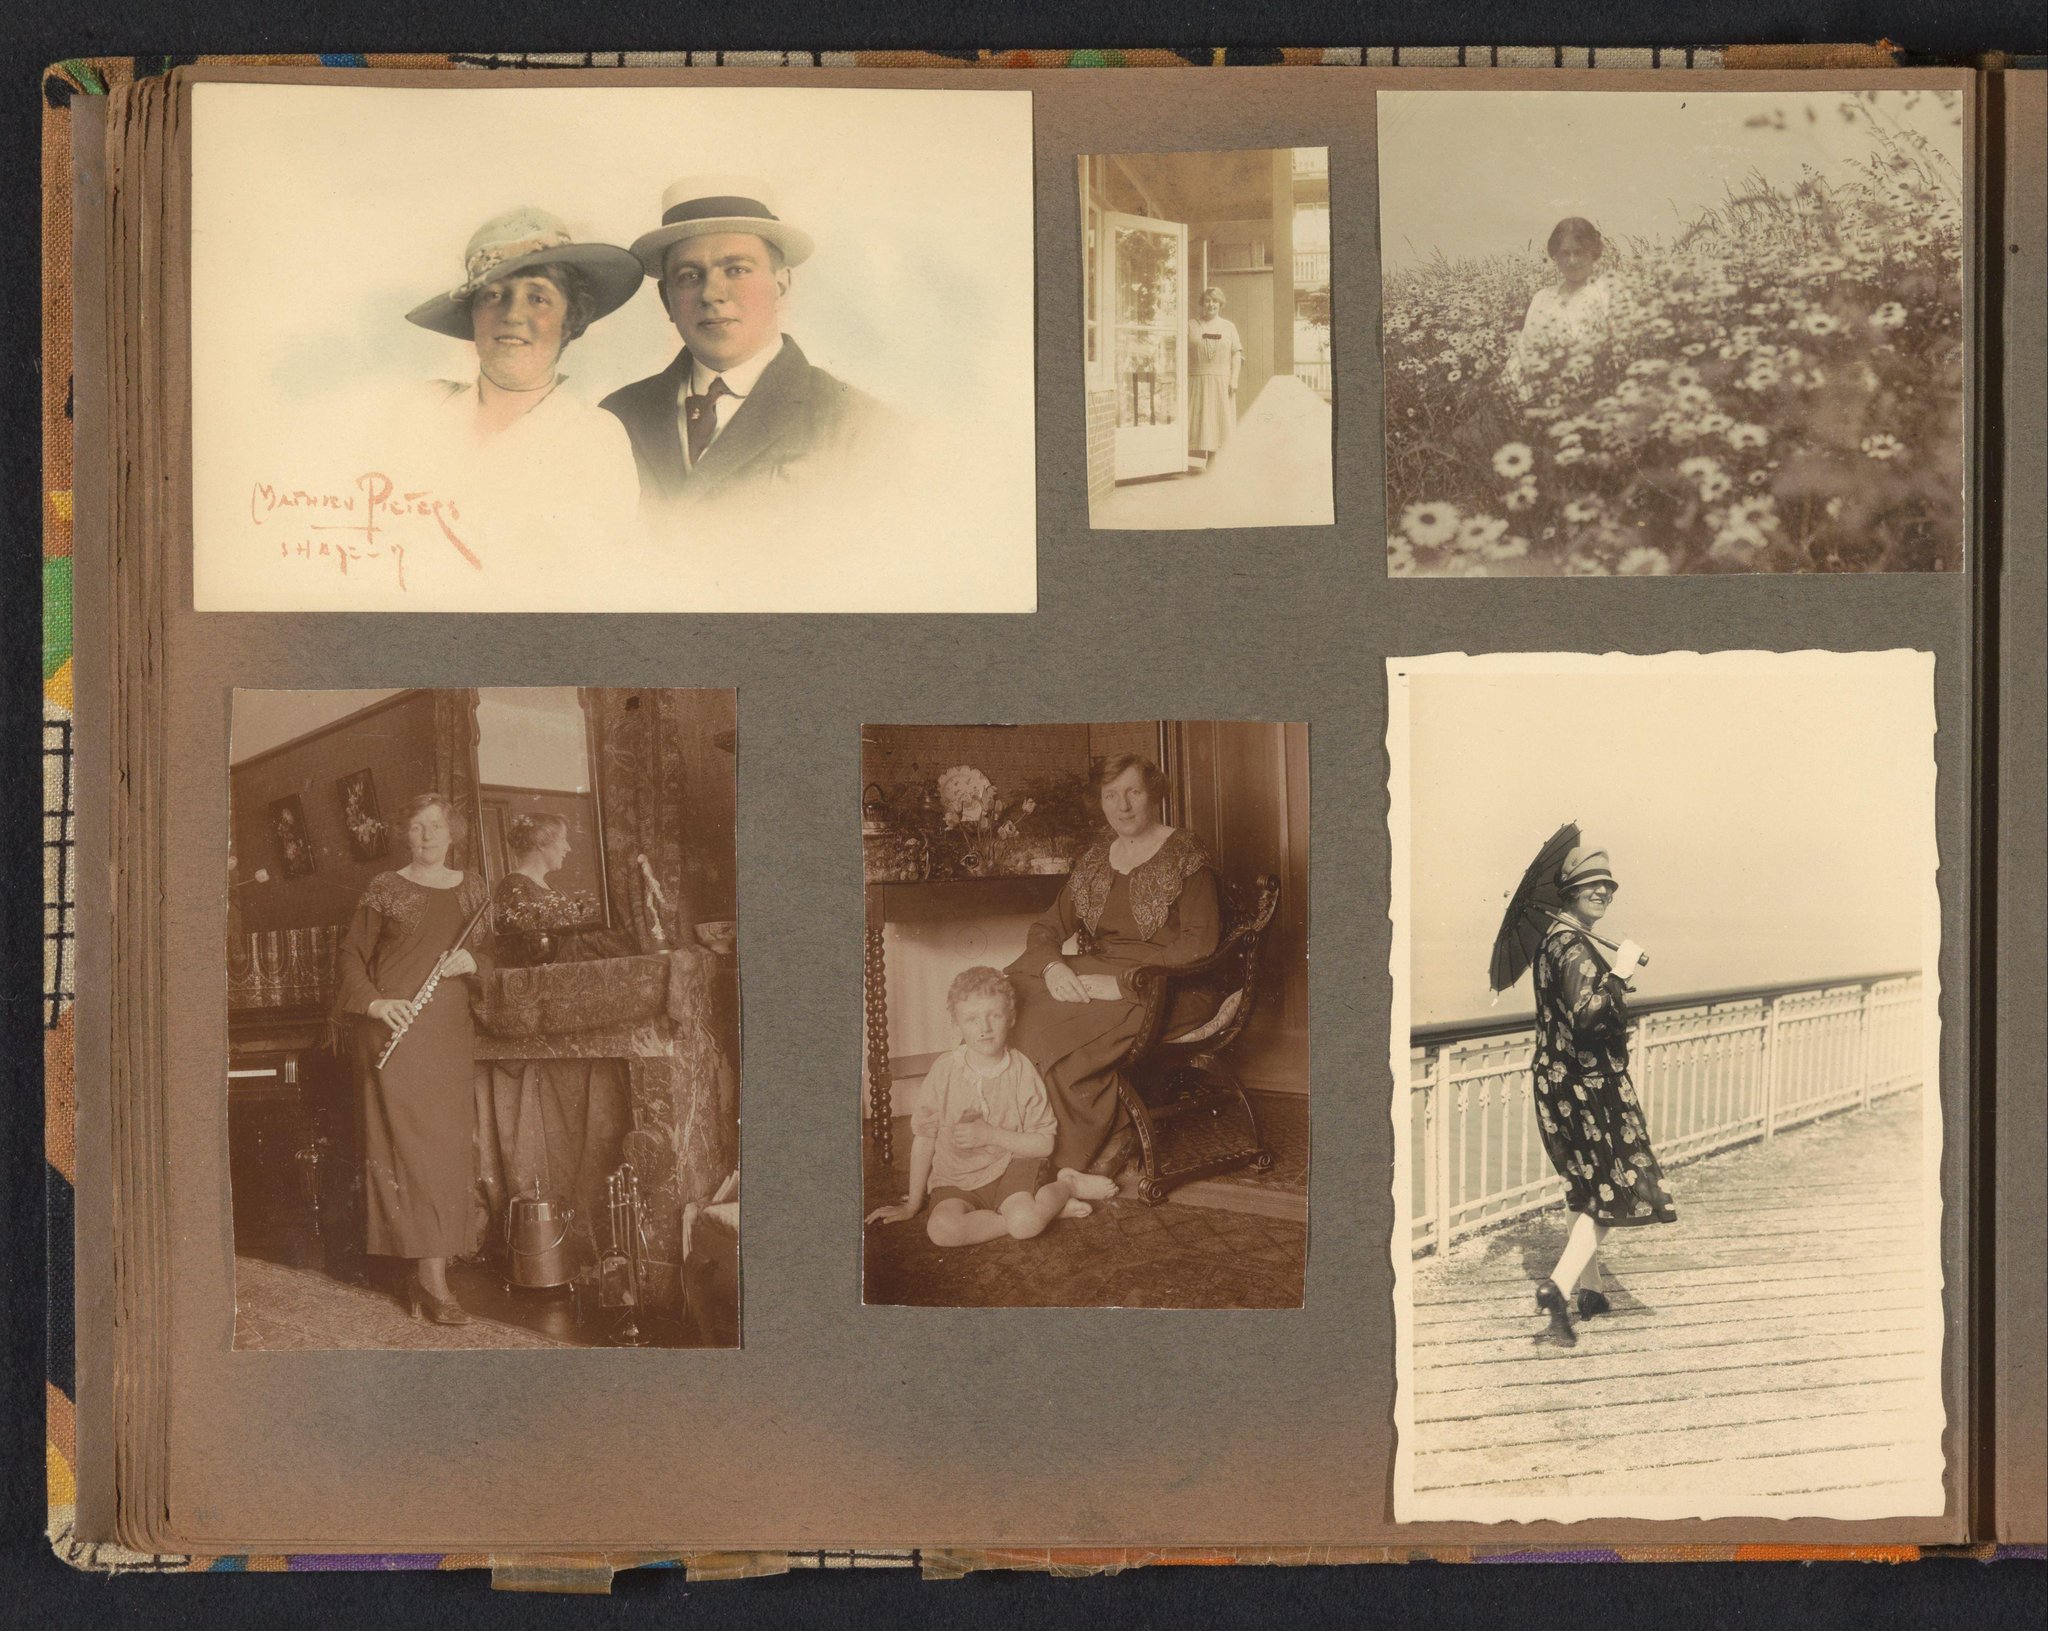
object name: photograph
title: Portretten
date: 1900-1925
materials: cardboard, photographic support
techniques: gelatin silver print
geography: netherlands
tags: adult woman, adult man, mother and baby or young child, pier, quay, wharf, flute, aulos, tibia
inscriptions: inscription: ‘Mathieu Pieters 's Hage [...]’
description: Albumblad met onder meer foto's van een stel, van een vrouw met een dwarsfluit en met een kind. Ook een foto van een vrouw met een parasol op de pier van Scheveningen. Onderdeel van Fotoalbum van een onbekende Nederlandse familie met connecties in Suriname en Nederlands-Indië (2).